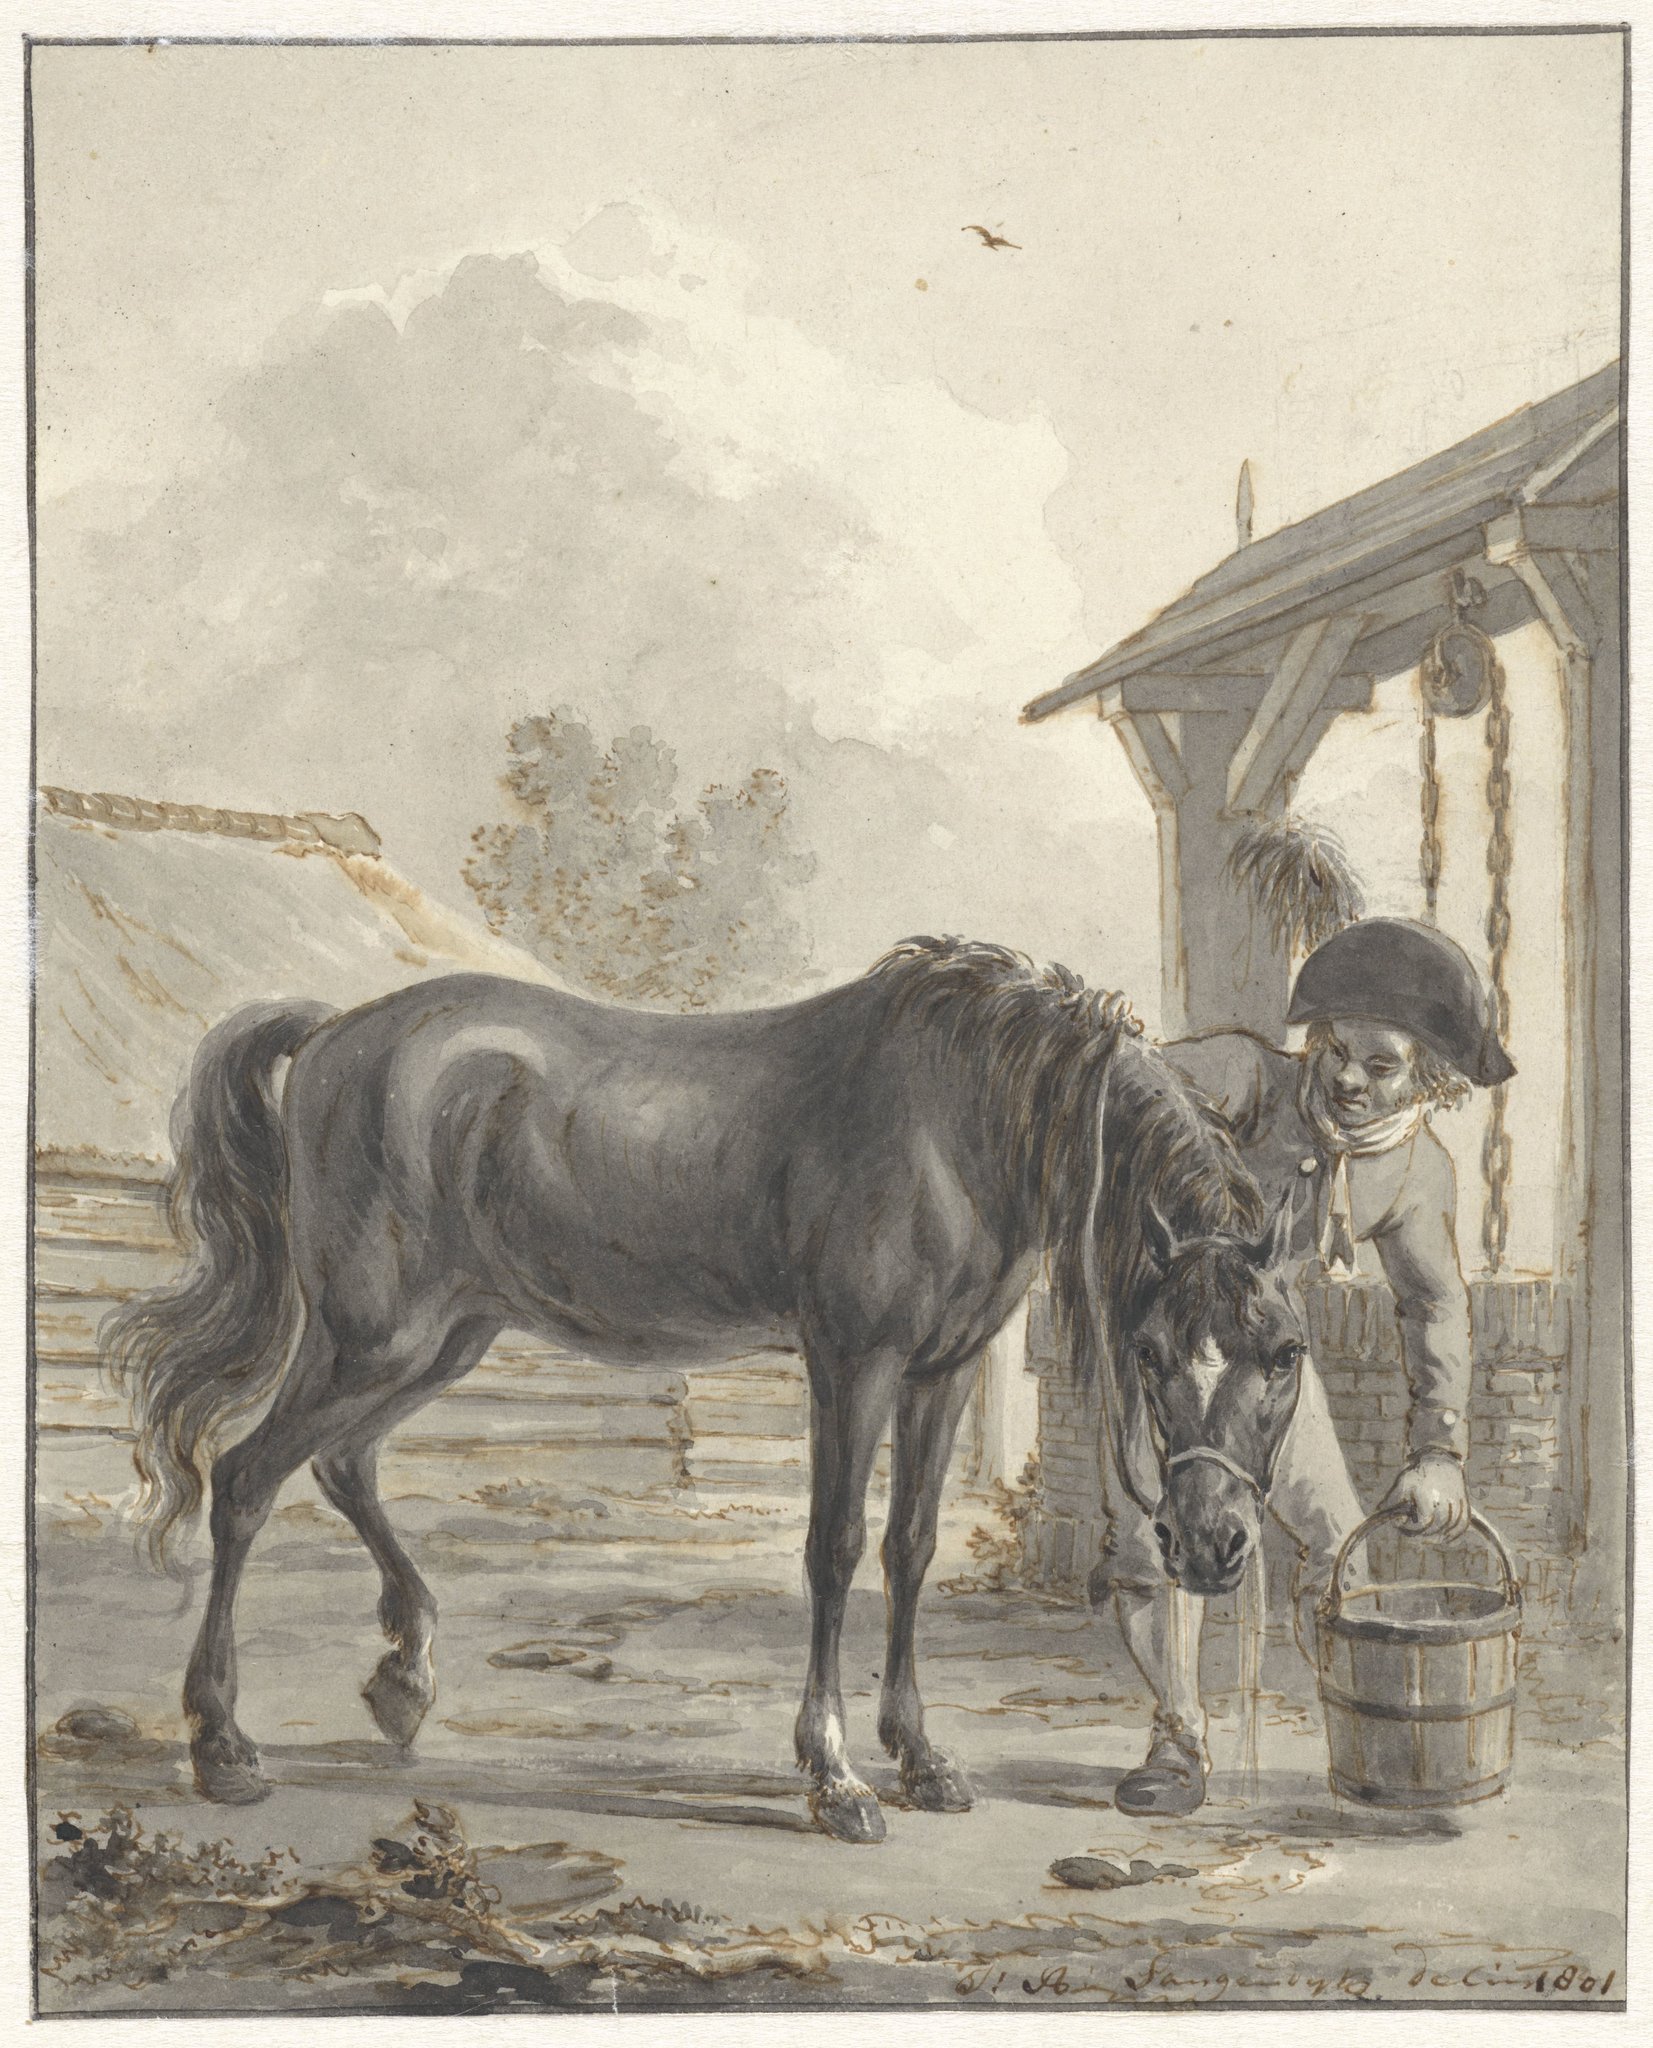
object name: design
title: Man laat een paard uit een emmer drinken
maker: jan anthonie langendijk dzn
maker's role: draughtsman, print maker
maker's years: 1780-1818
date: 1801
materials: ink, paper, pencil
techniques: brush, pen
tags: horse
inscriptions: date: ‘1801’